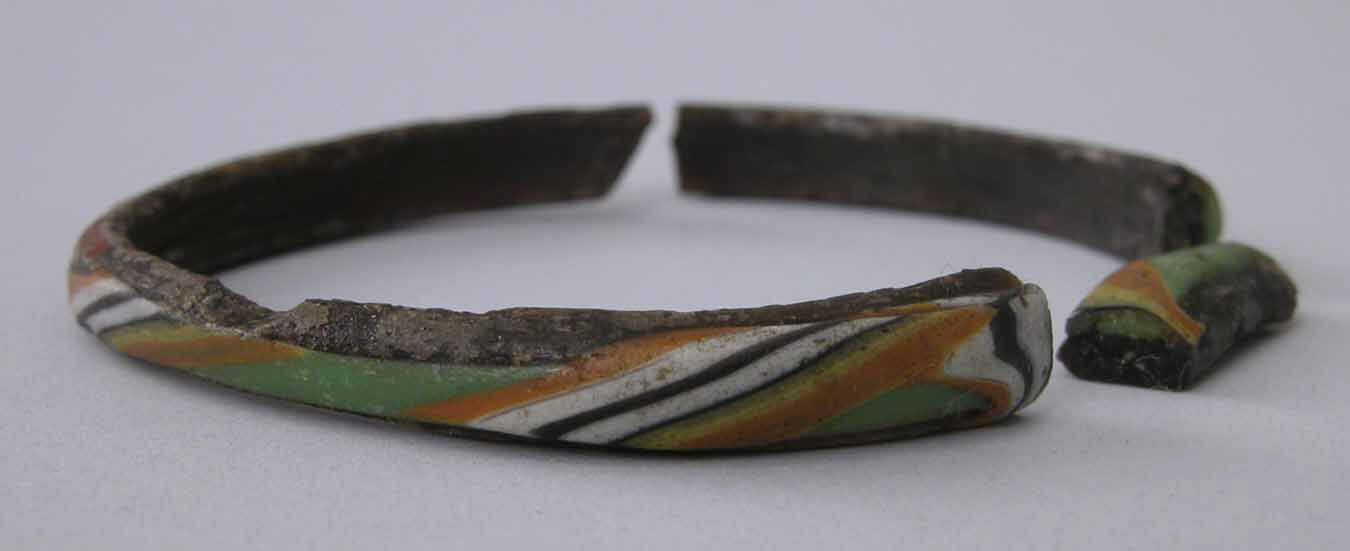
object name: bracelet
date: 1301-1500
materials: glass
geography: egypt or syria